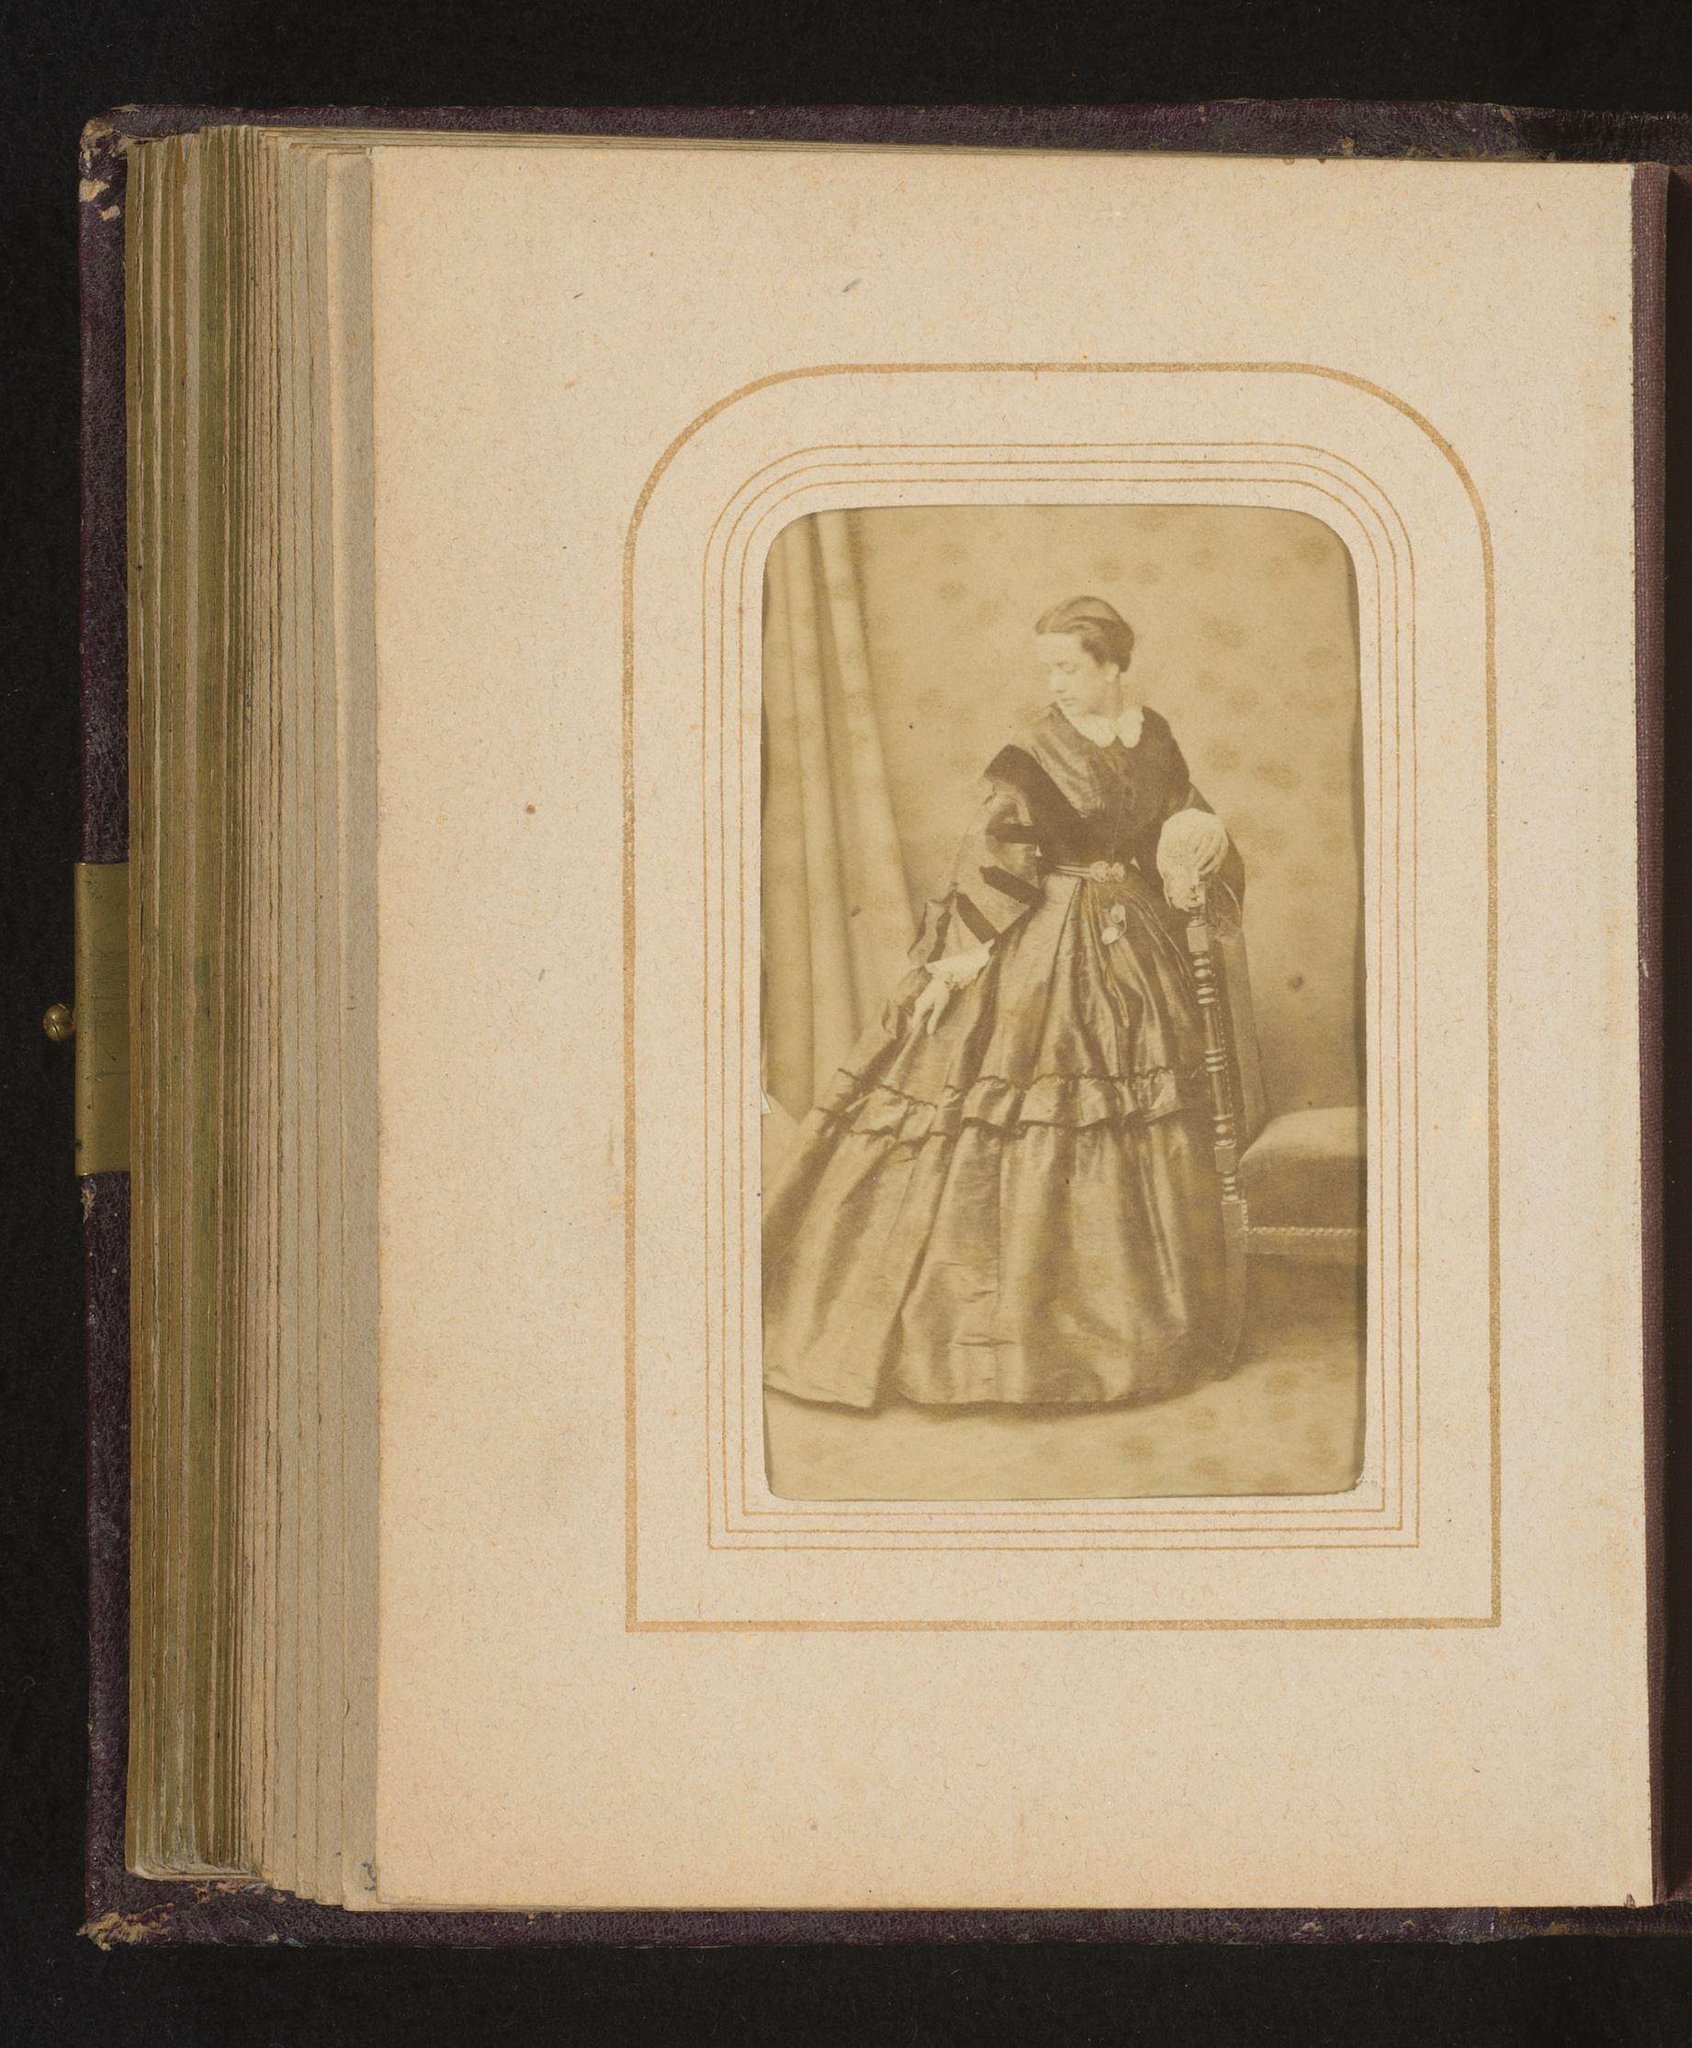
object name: photograph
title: Portret van een staande vrouw, aangeduid als Ramona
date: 1860-1900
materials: cardboard, photographic support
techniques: albumen print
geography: algiers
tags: historical persons - bb - woman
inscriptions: annotation: ‘A mi querido hermano tu hermanita/ Ramona’